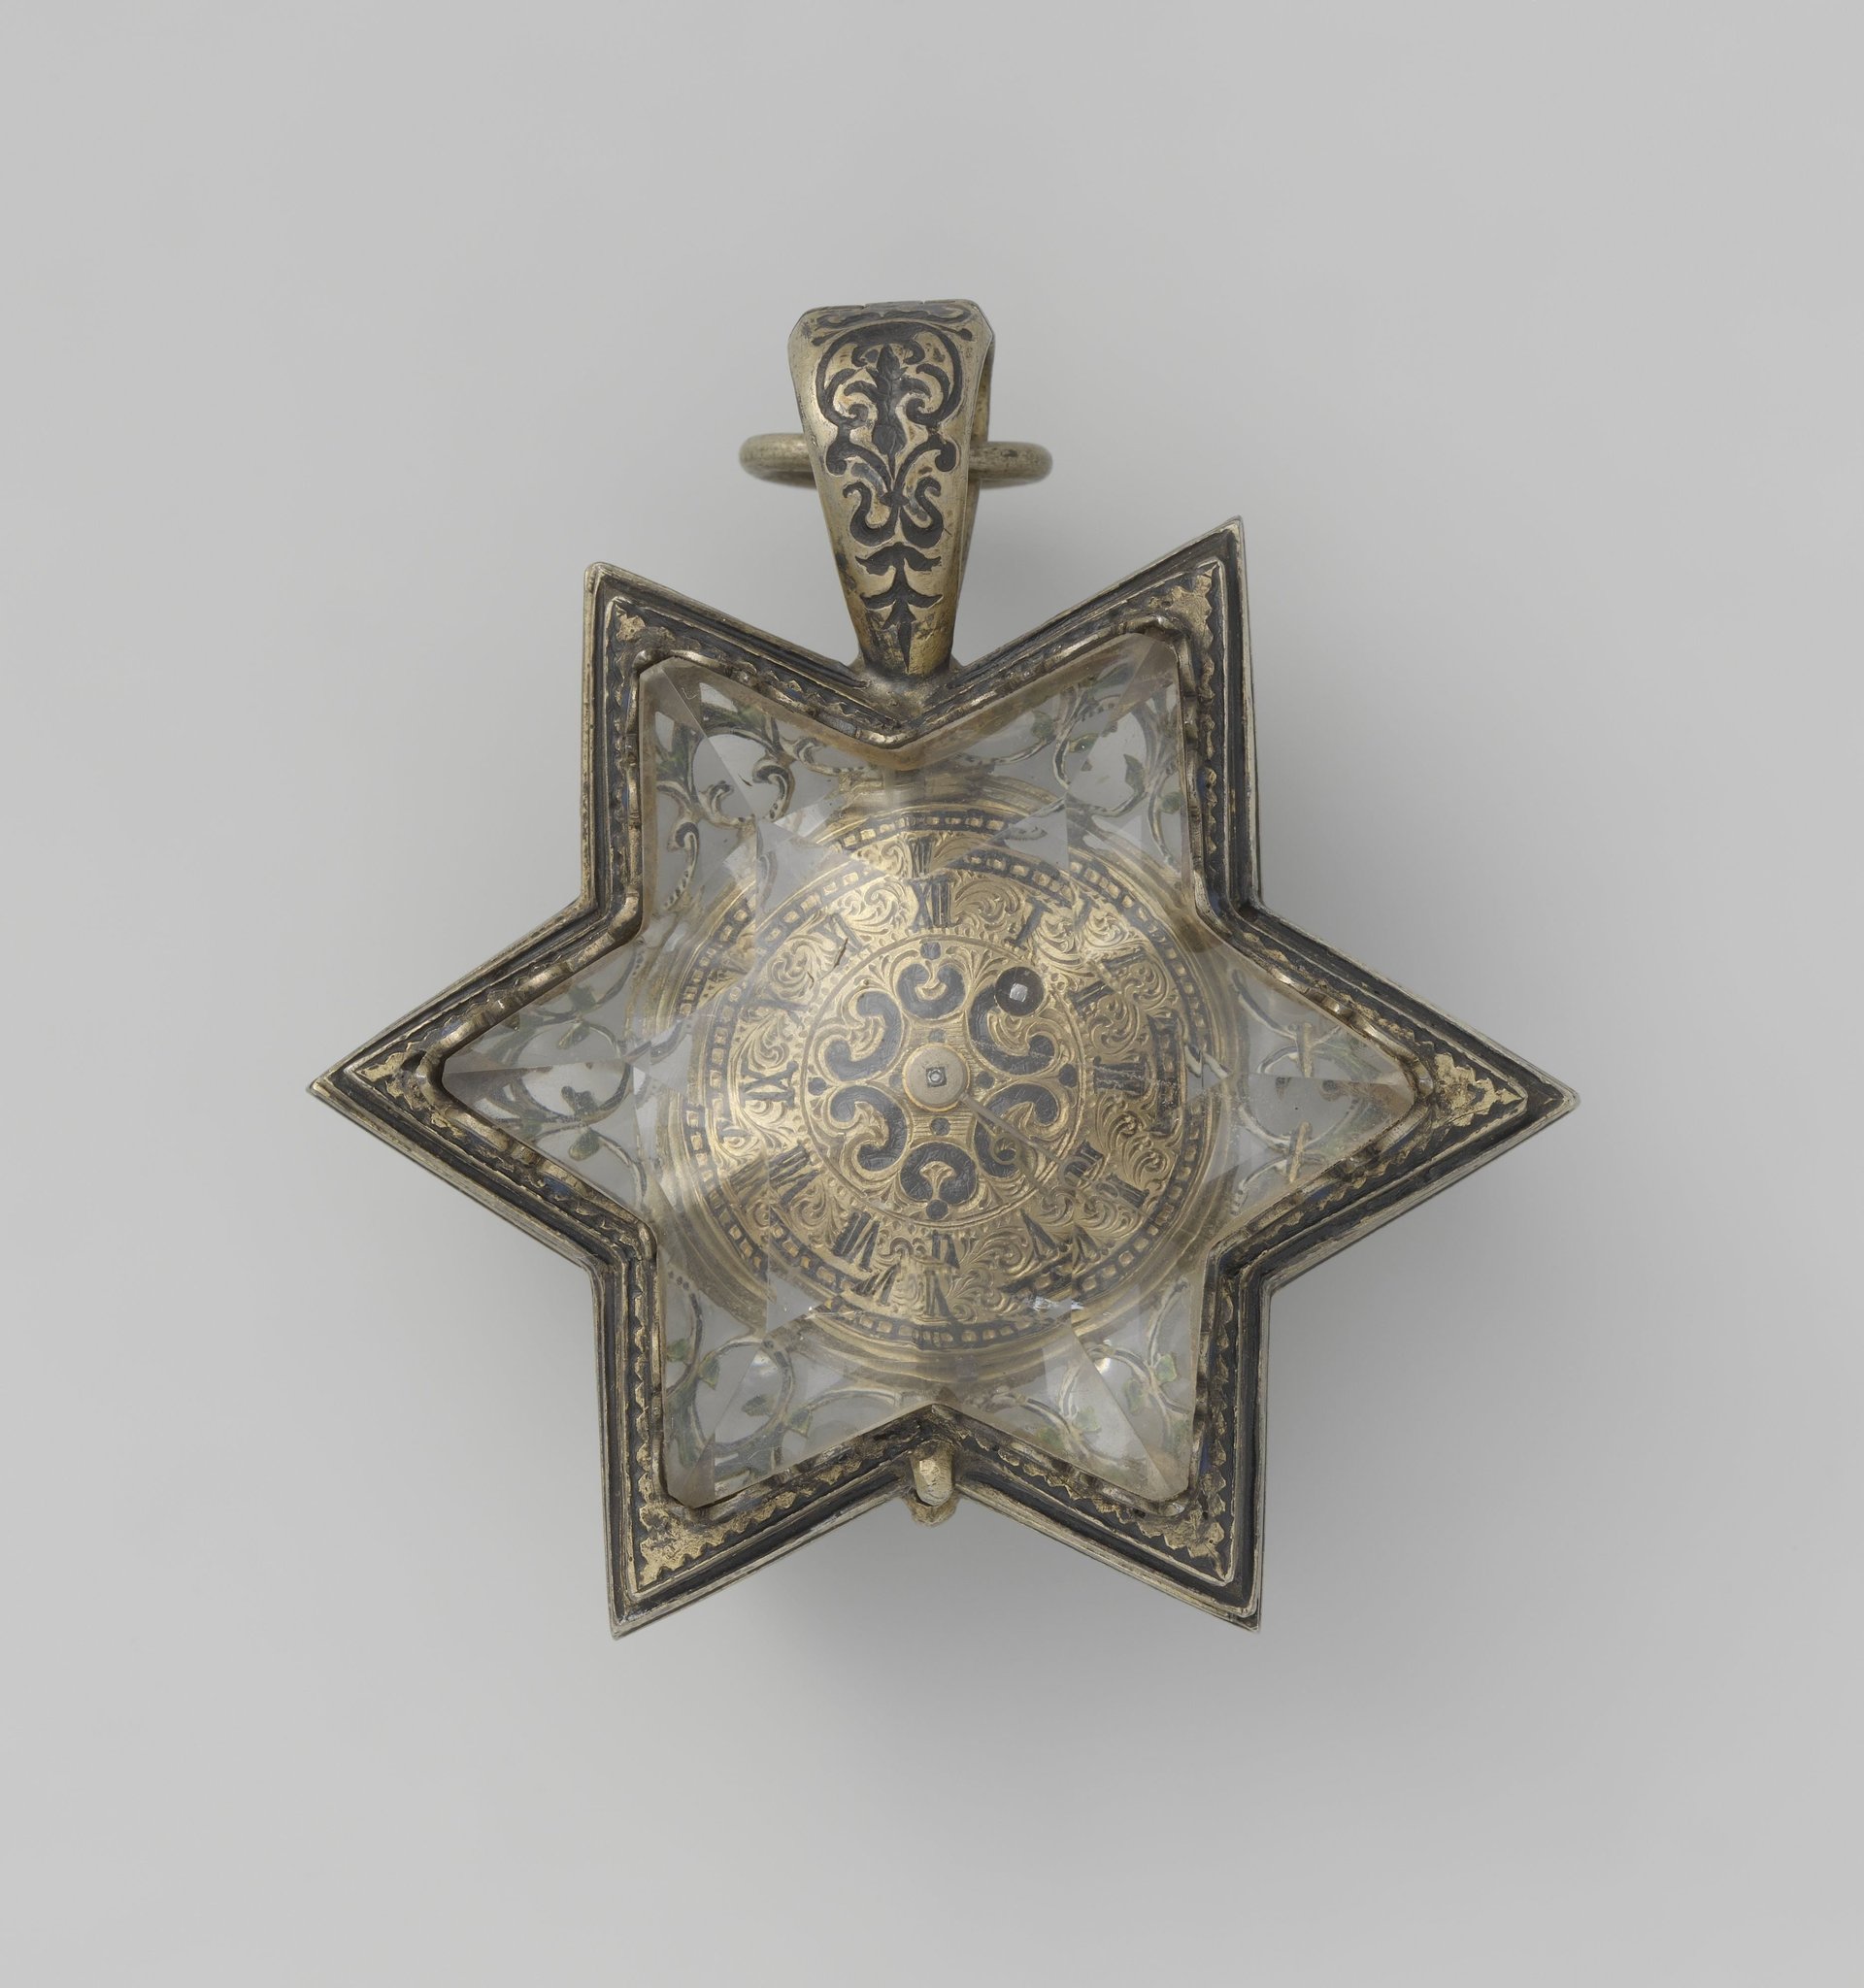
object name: wrist watch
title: Star-shaped Watch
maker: Anonymous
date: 1825-1850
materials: copper, crystal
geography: central europe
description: Stervormig horloge van kristal met een verguld zilveren montuur en een geëmailleerde haak.